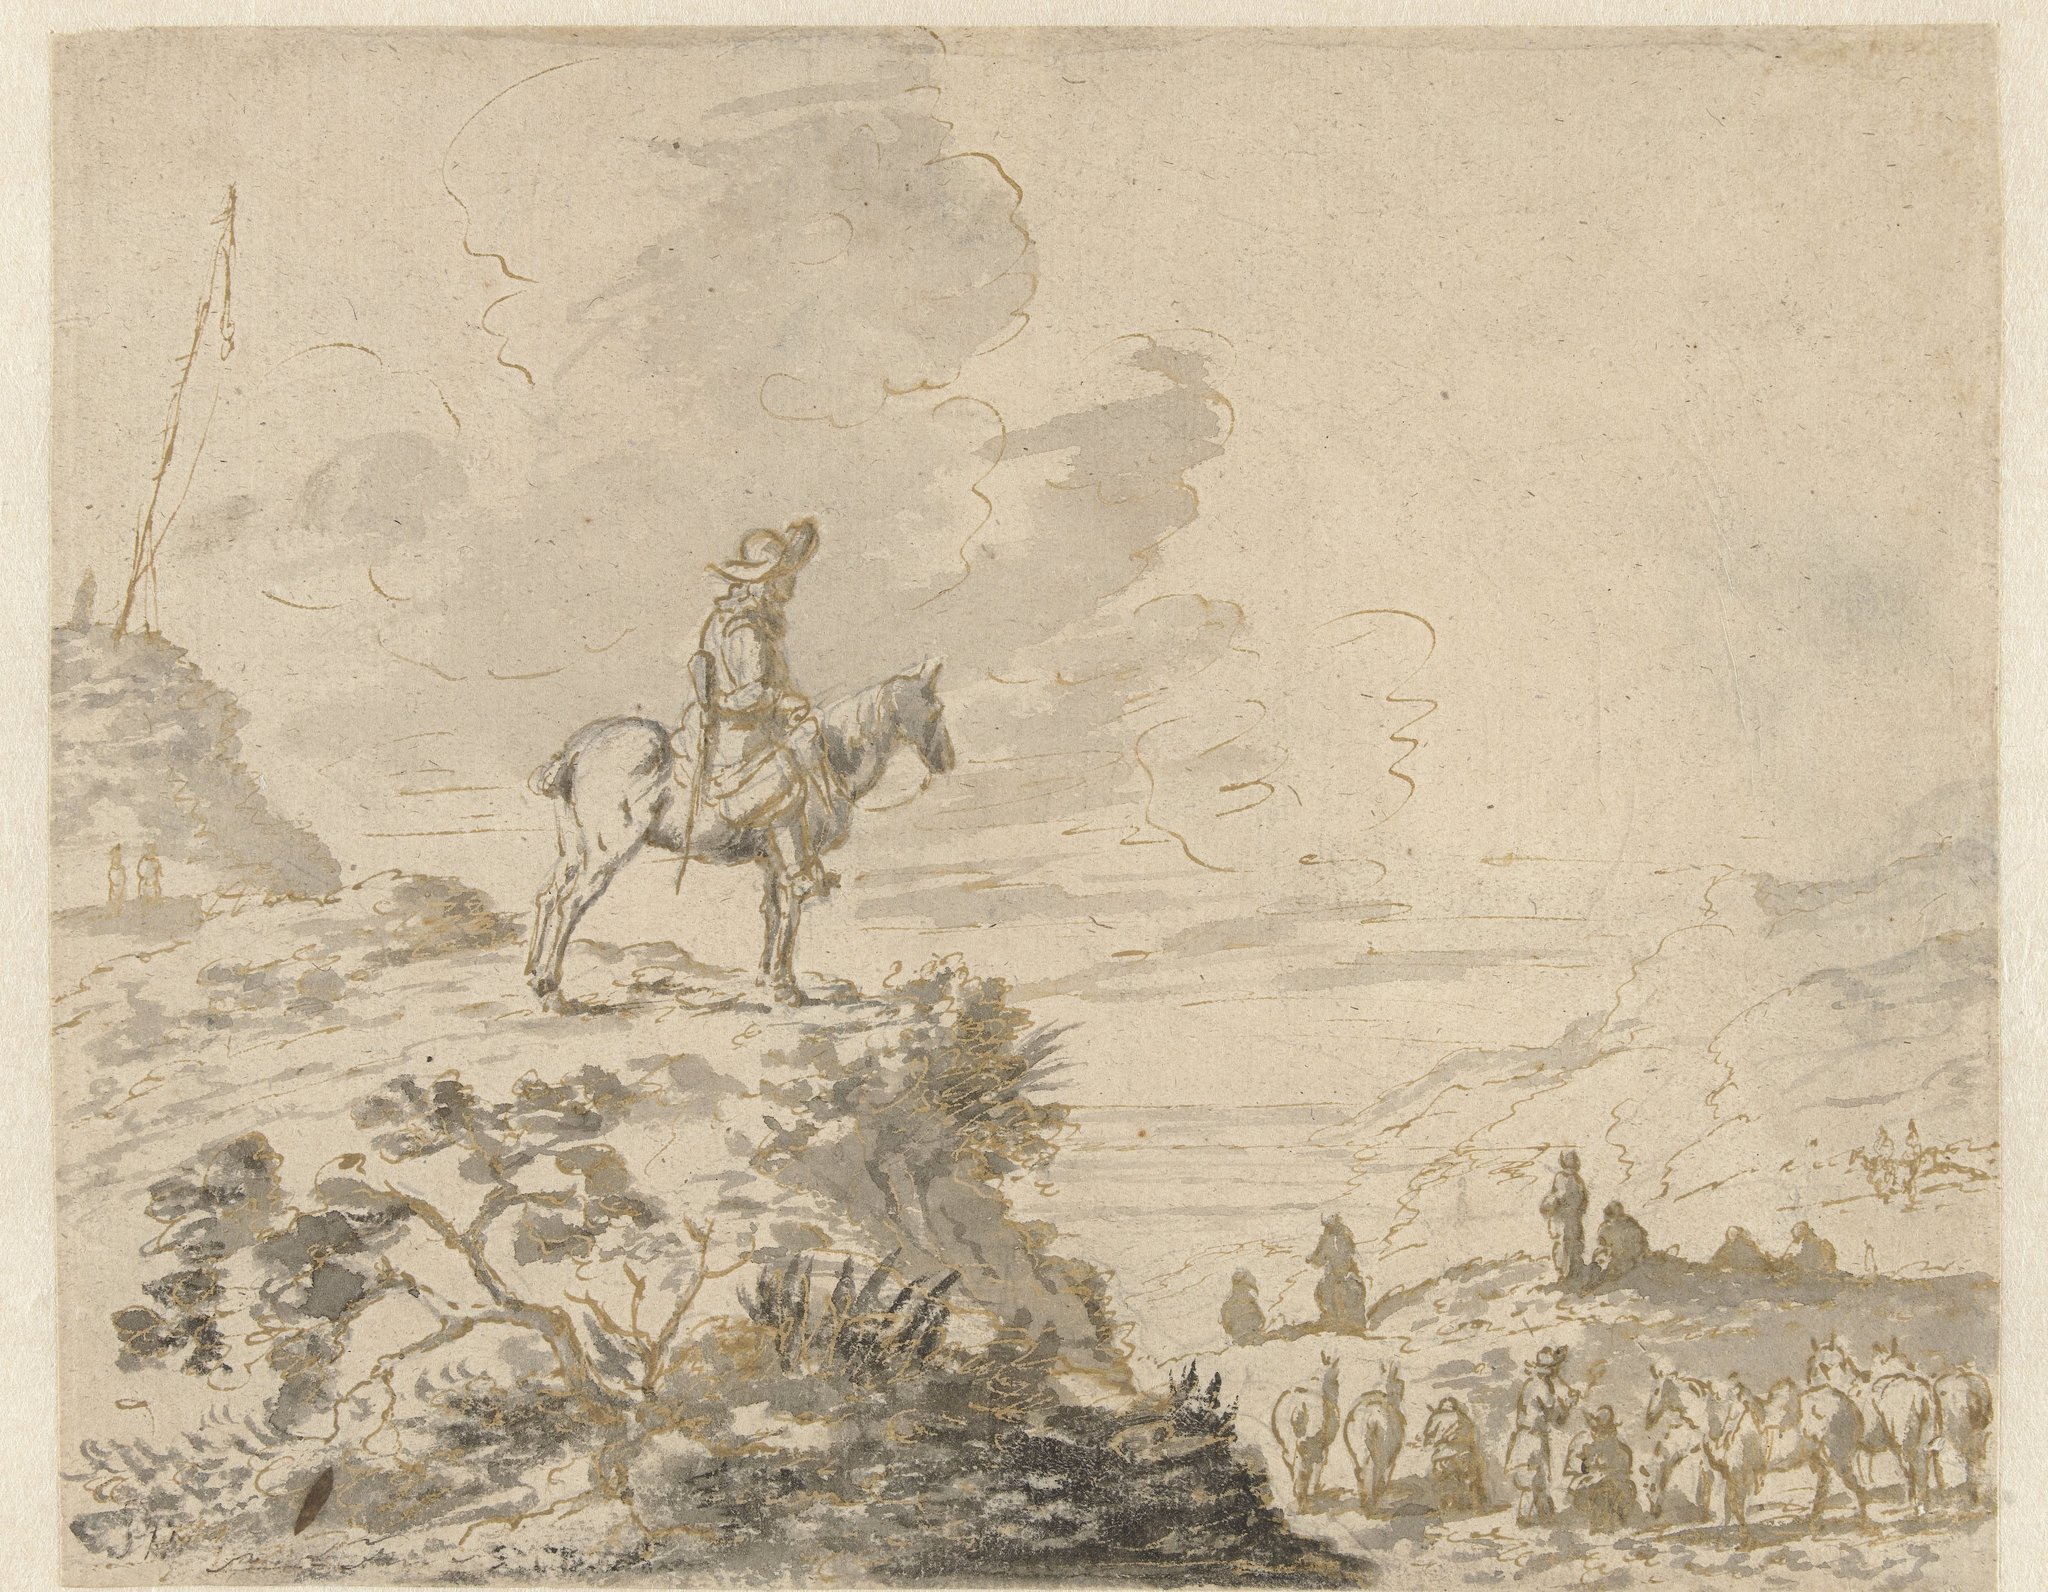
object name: drawing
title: Mounted Sentry Overlooking a Panoramic Landscape with Soldiers and Horses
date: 1625-1699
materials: graphite, ink, paper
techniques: brush, pen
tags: land forces (+ cavalry, horsemen), (military) camp with tents, guard duty, keeping sentry